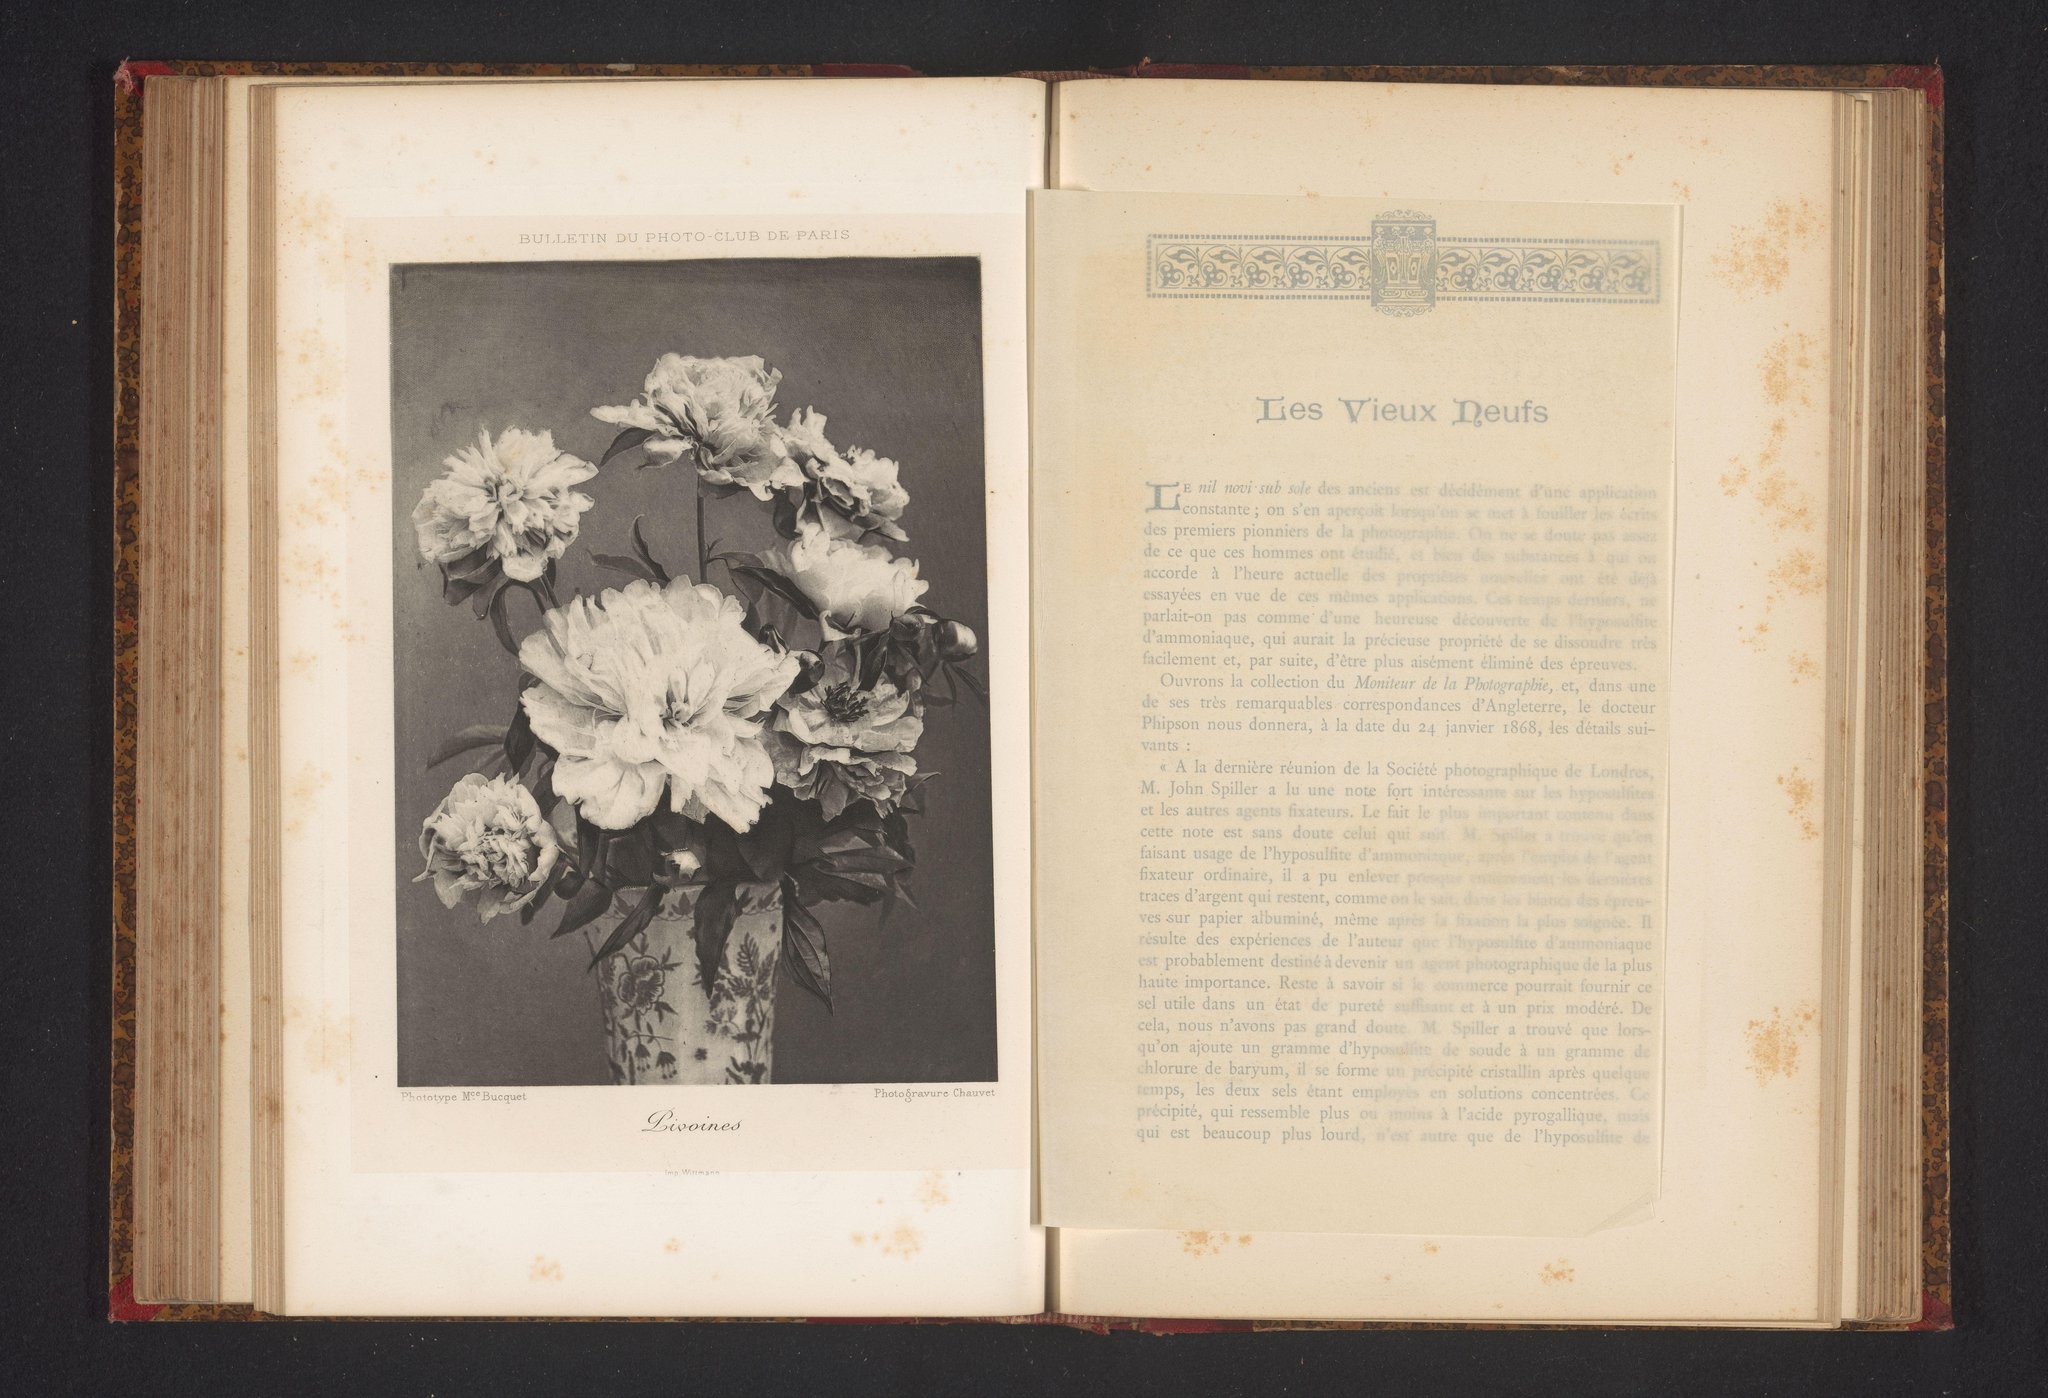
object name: page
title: Pivoines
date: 1888-1893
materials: paper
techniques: photoaquatint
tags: plants and herbs: peony, flowers in a vase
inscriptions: inscription: ‘Bulletin du Photo-Club de Paris’